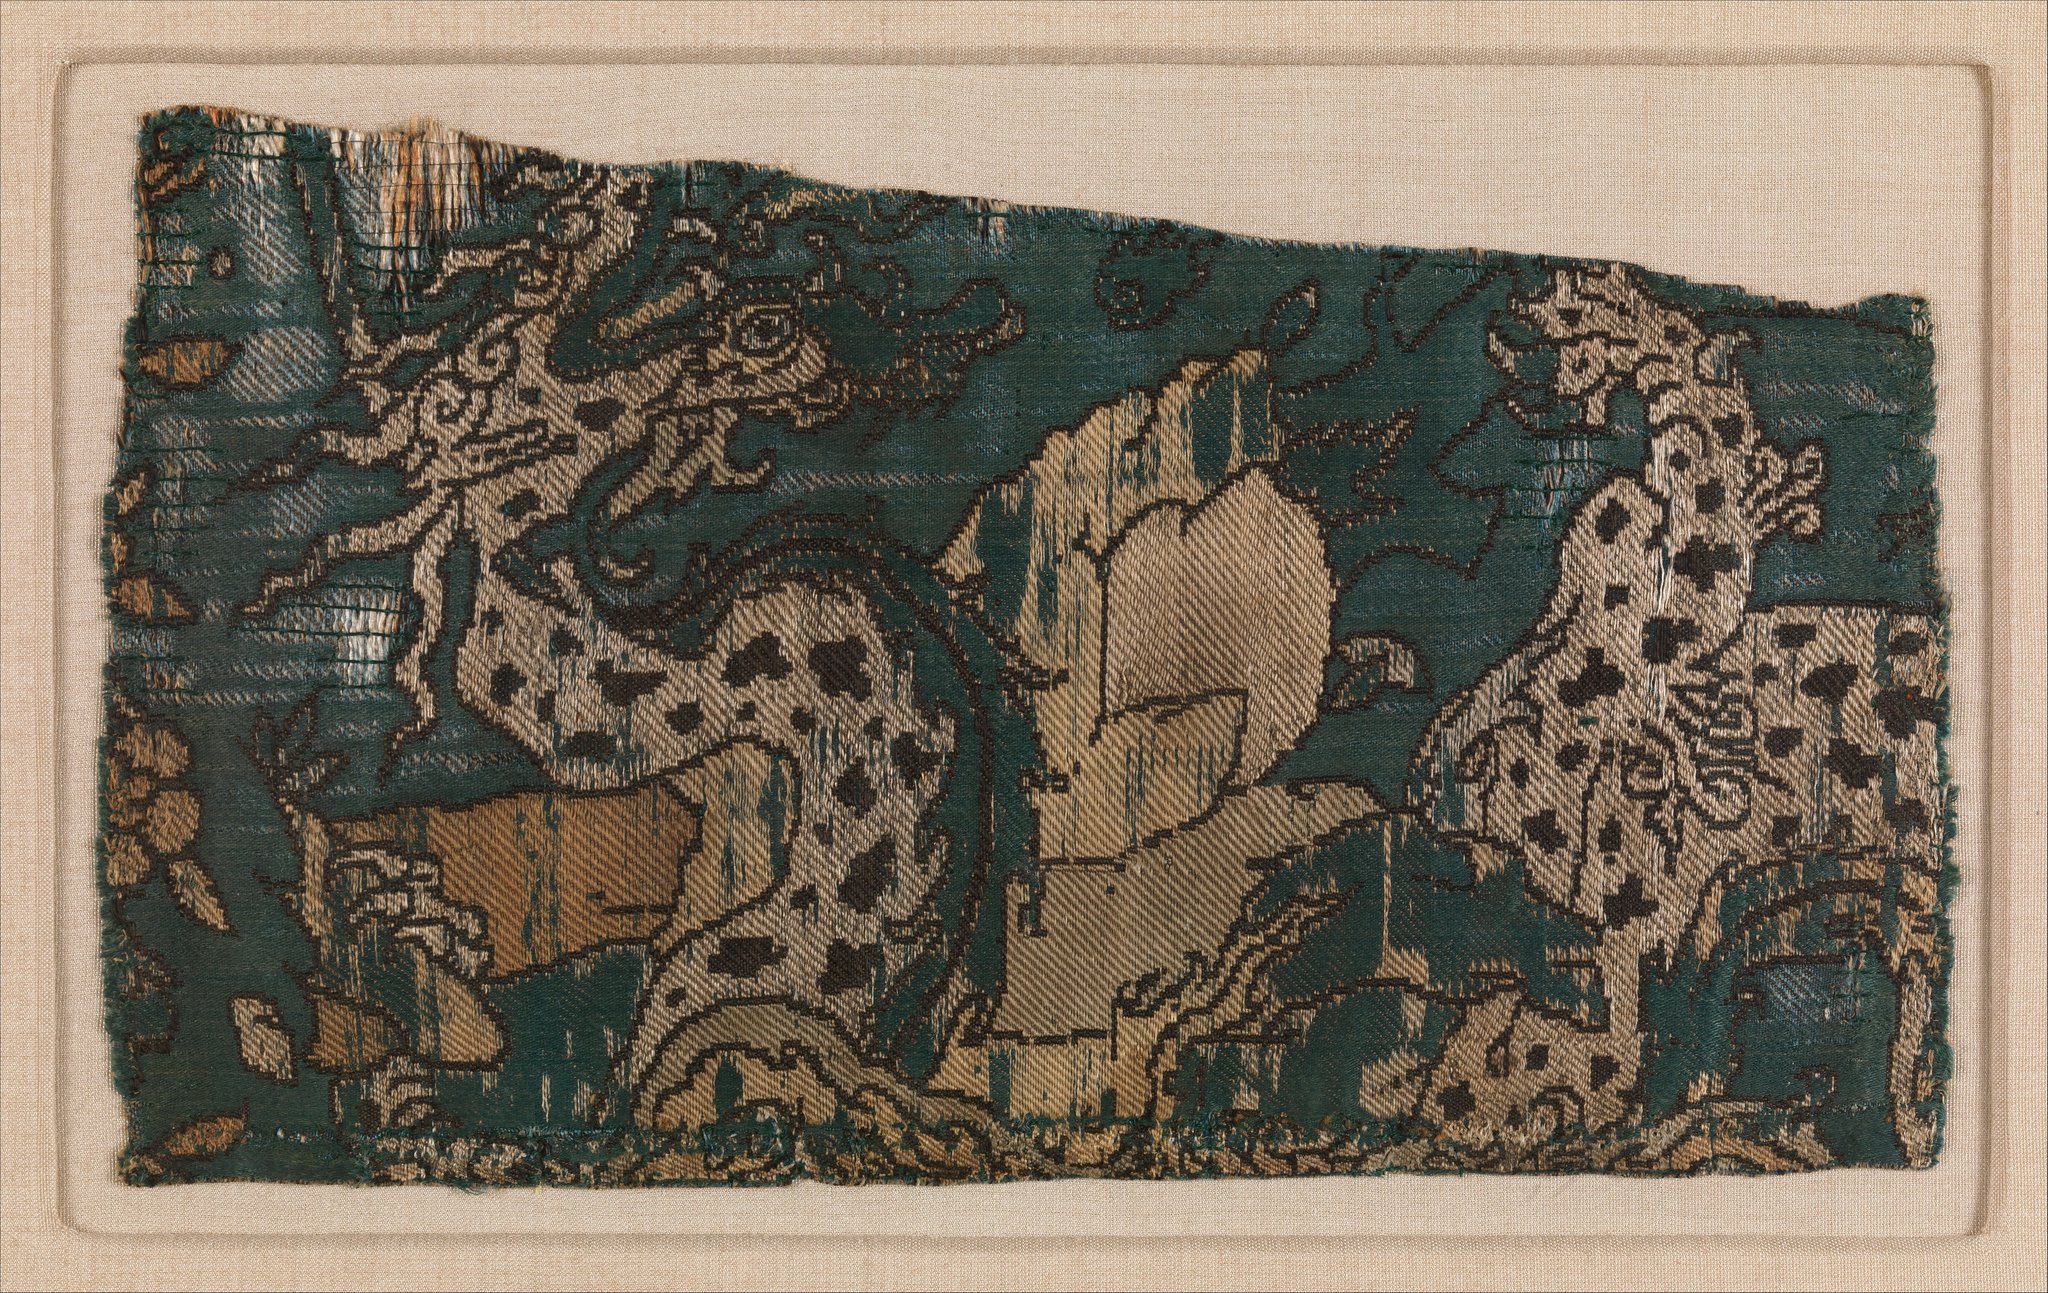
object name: textile fragment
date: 1534-1566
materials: metal, textile, silk, thread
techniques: compound weave, weave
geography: iran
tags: dragons